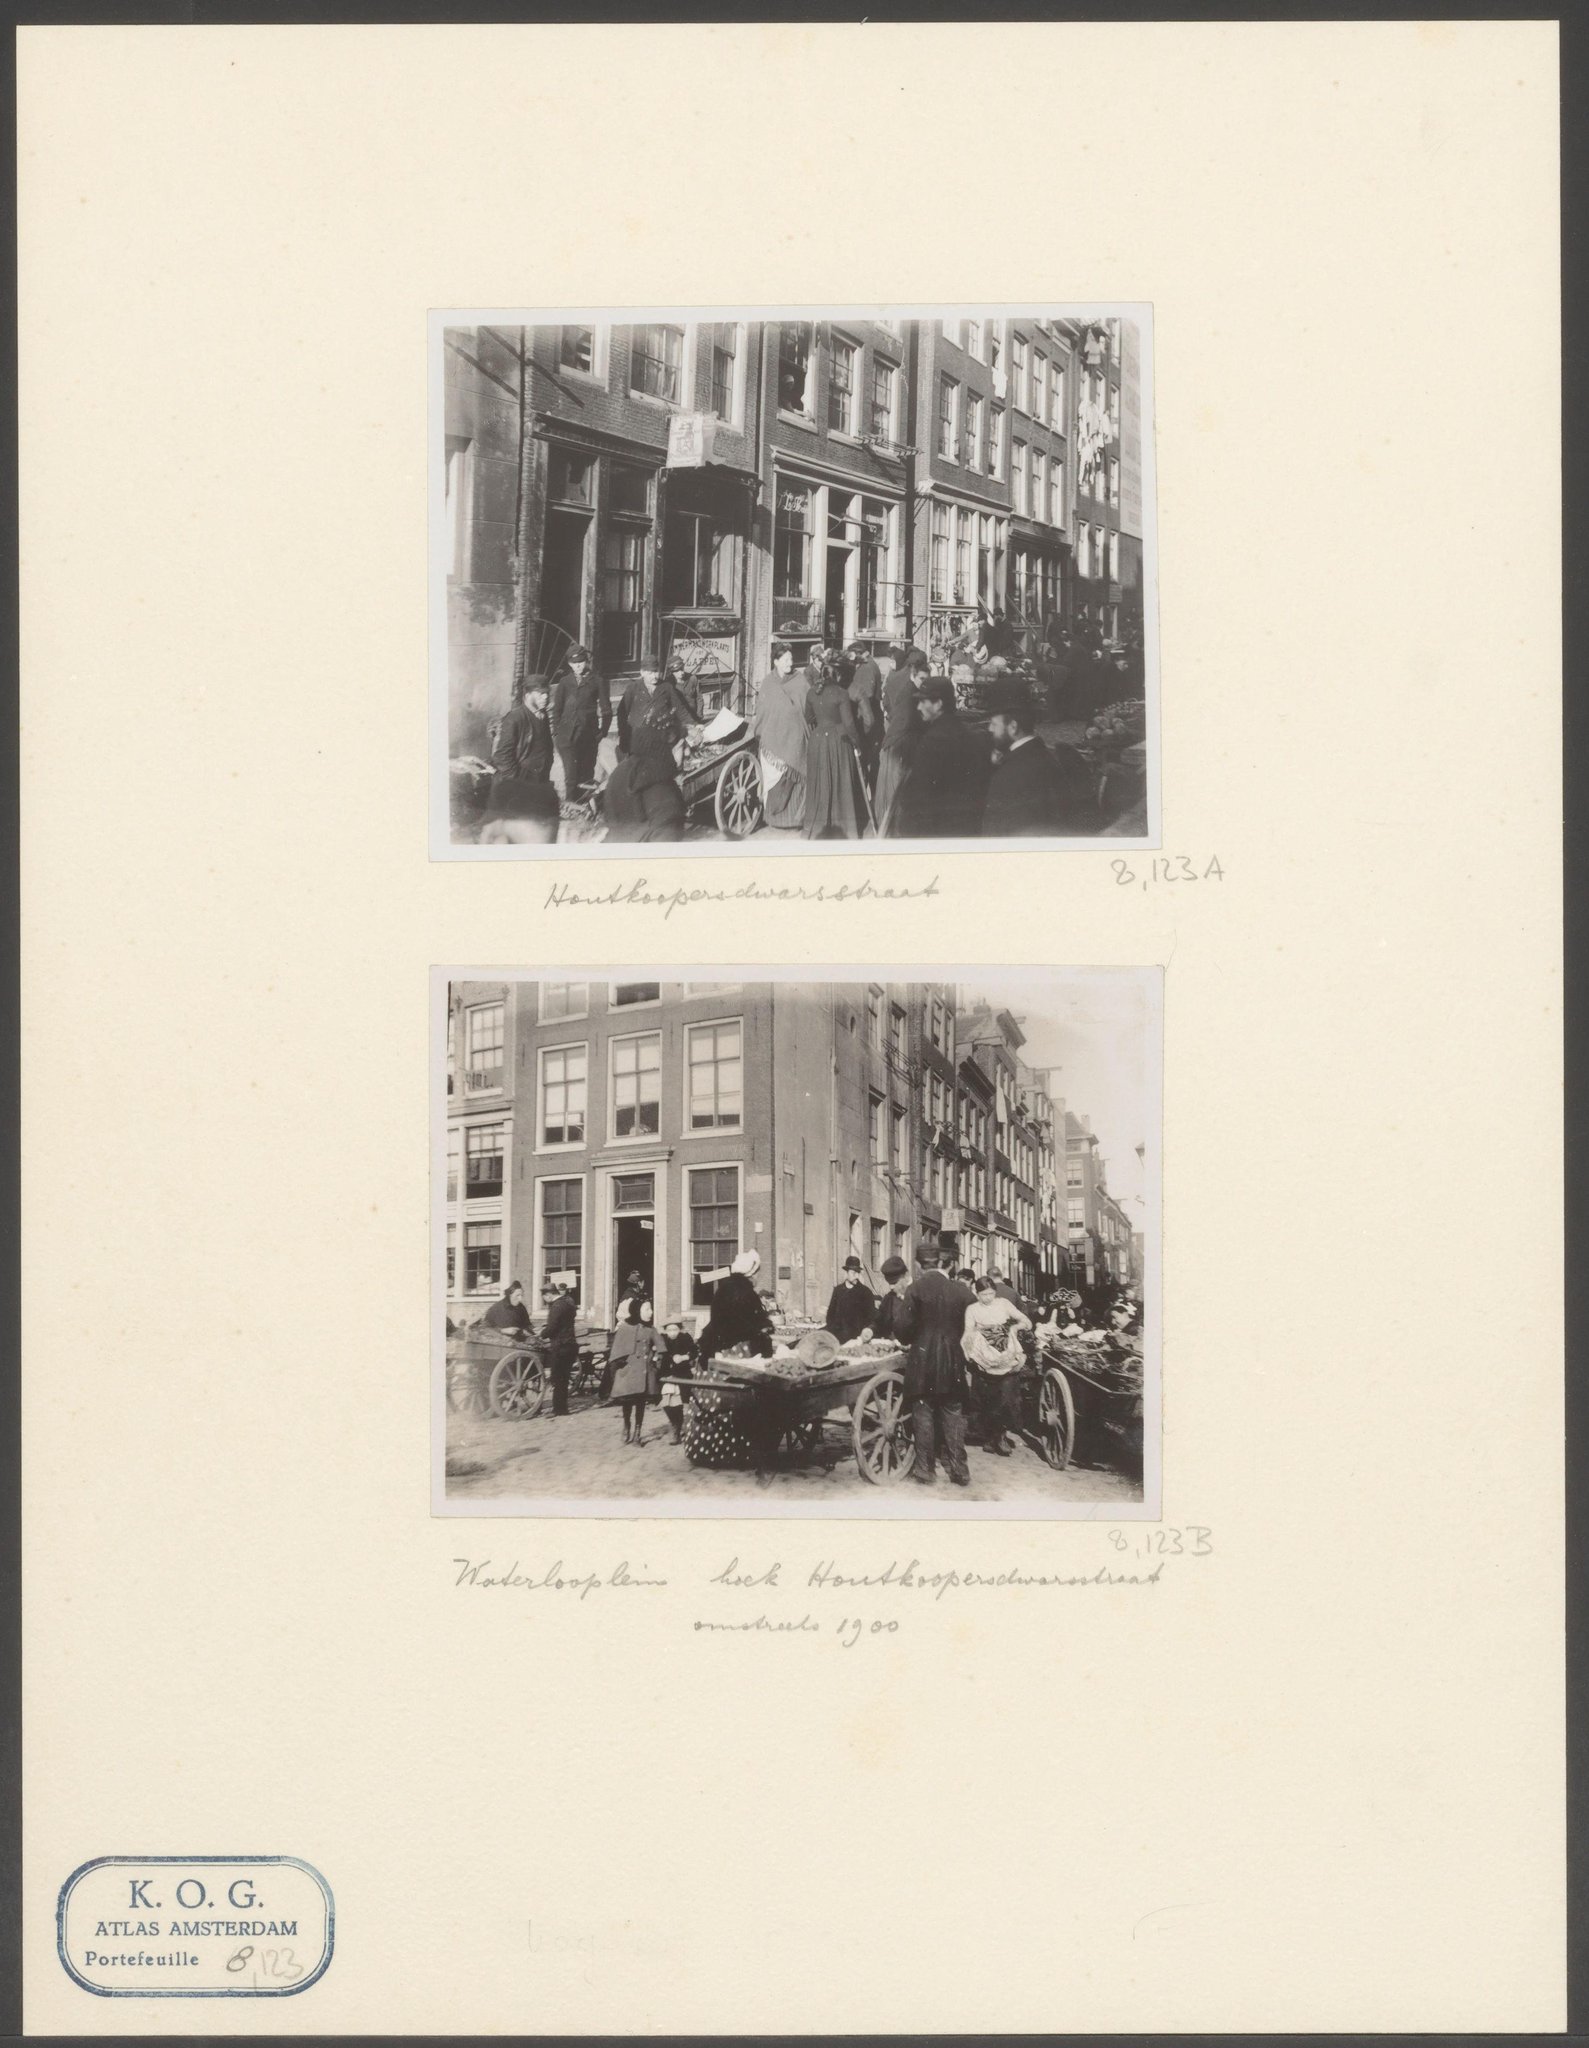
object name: photograph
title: Gezicht op de Houtkopersdwarsstraat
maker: Anonymous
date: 1880-1950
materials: paper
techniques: gelatin silver print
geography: amsterdam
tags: city-view in general; 'veduta', street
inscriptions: inscription: ‘Houtkoopersdwarsstraat’, collector's mark: ‘8,123’ Lugt 1641b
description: Onderwerpsrubriek binnen de Atlas Amsterdam: Heerengracht (Nieuwe), Heiligeweg, Heisteeg, Heintjehoeksteeg, Hekelveld, Hemelrijk, Hoedemakerspad, Hol (‘t), Houtgracht, Houtewaelerboom, Houtkoopersdwarsstraat, Houttuinen (Joden), Houttuinen (Haarlemmer), Hugo de Grootkade, Huidenstraat, Huidenvetterstraat, Huydecoperstraat.